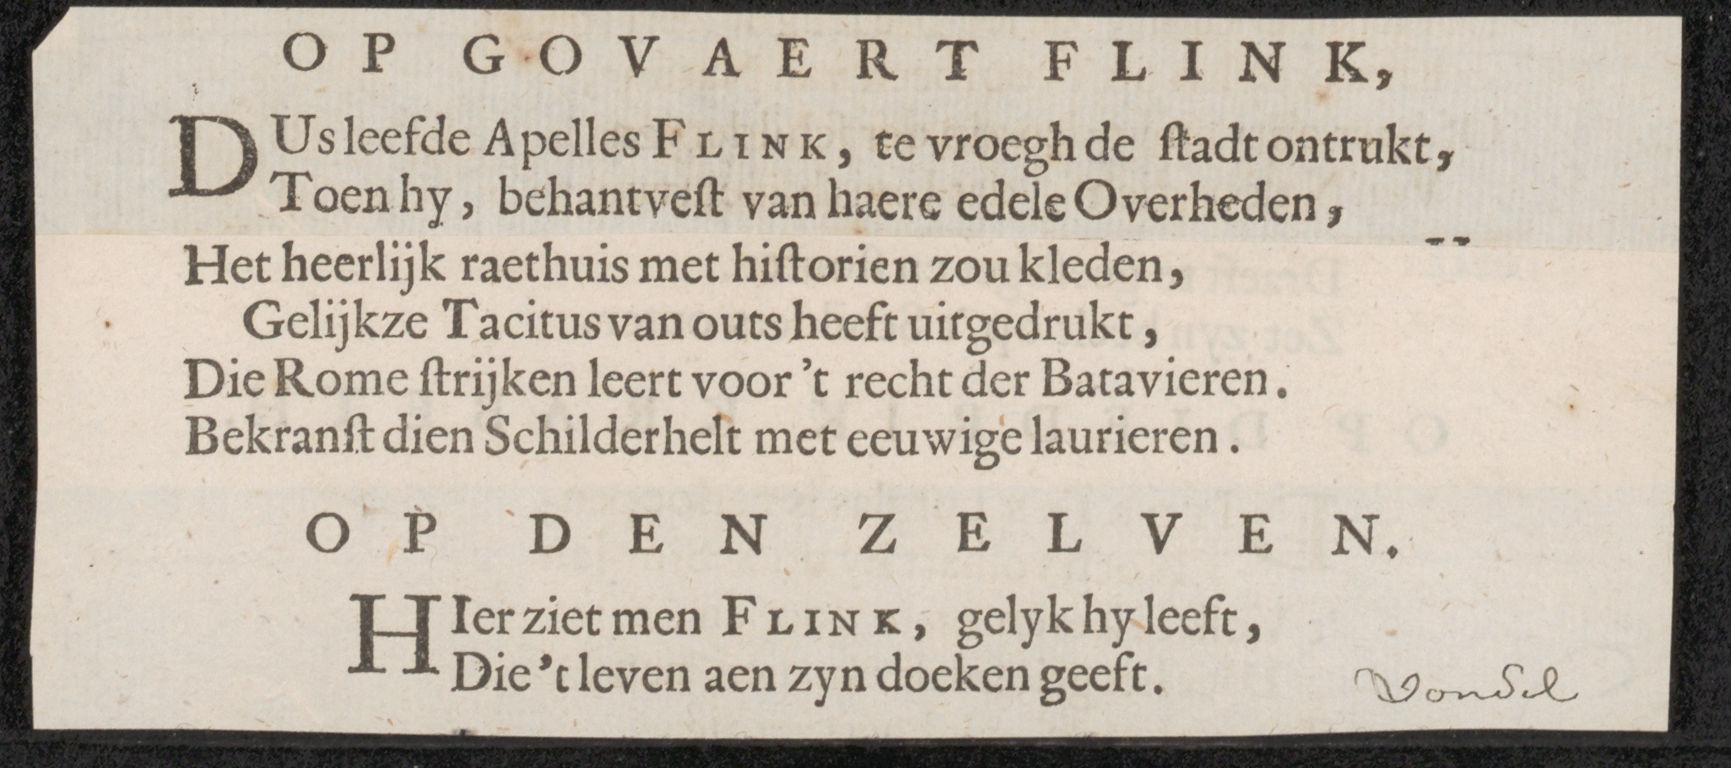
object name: poem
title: Gedicht op Govert Flinck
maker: joost van den vondel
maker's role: dichter, toneelschrijver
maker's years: 1587-1679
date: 1597-1679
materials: ink, paper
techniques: pen, printing, writing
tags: cleves, draughtsman, govert flinck